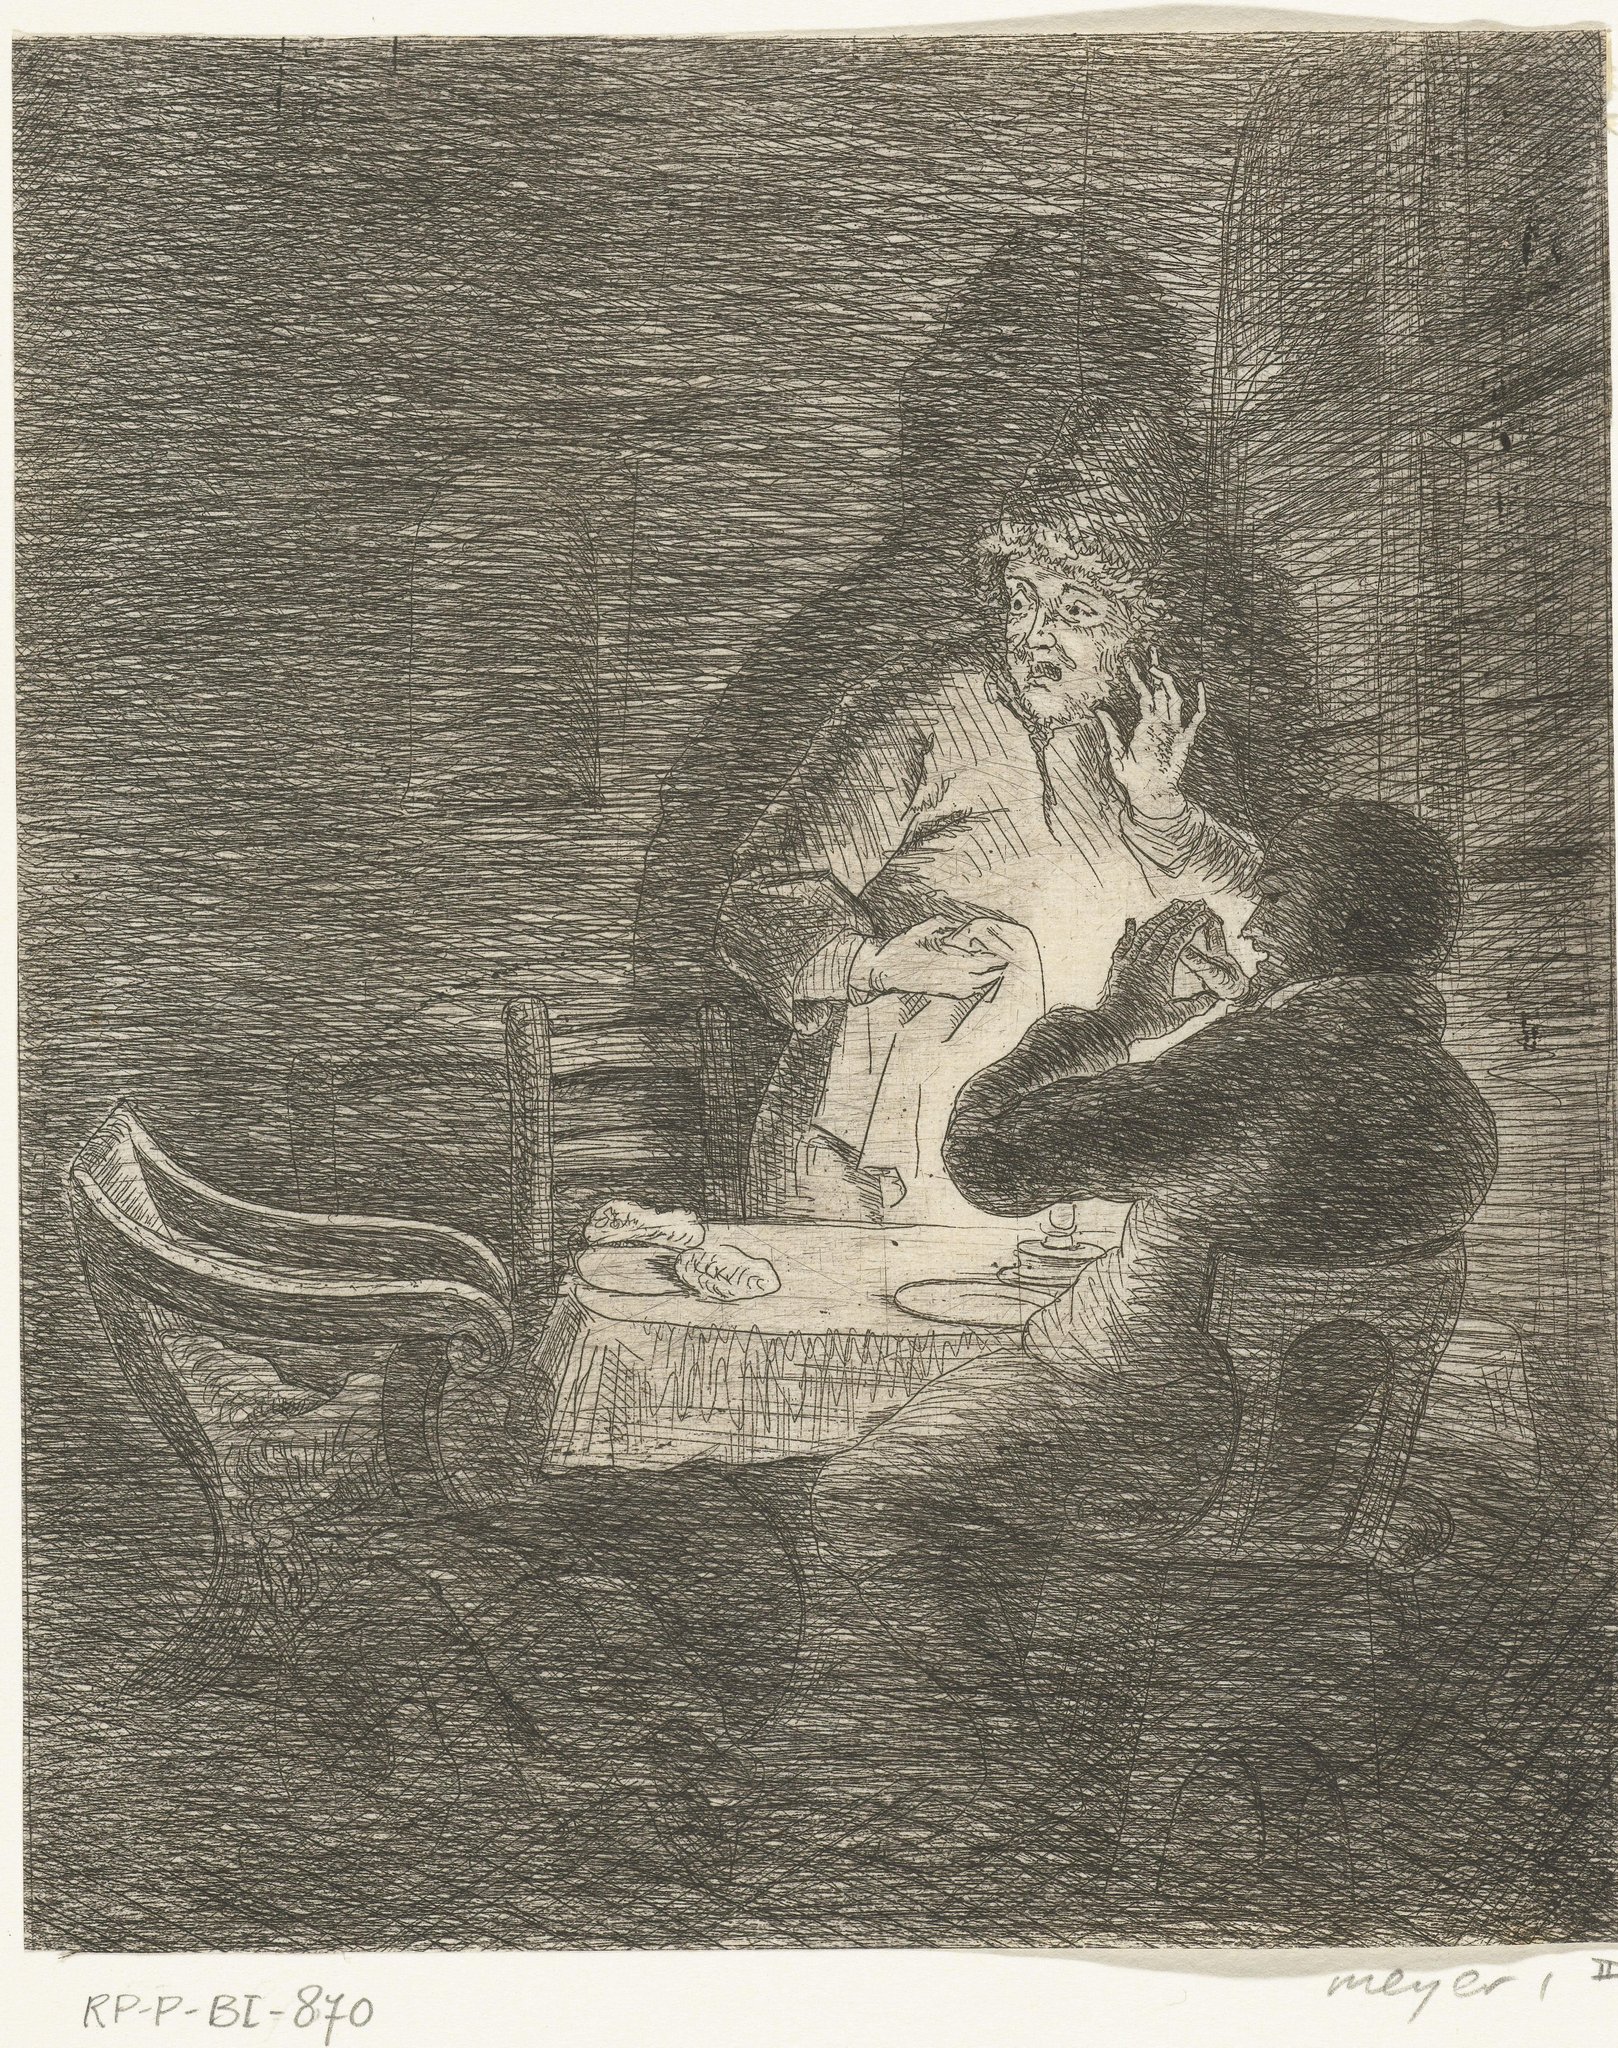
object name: print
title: Christus verdwijnt voor ogen van twee leerlingen tijdens maaltijd te Emmaus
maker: jonkheer isaac lambertus cremer van den berch van heemstede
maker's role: print maker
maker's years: 1811-1879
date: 1821-1879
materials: paper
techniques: etching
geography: netherlands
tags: christ vanishes ~ supper at emmaus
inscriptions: collector's mark: Lugt 2228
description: Prent naar ontwerp van Arnold Houbraken.